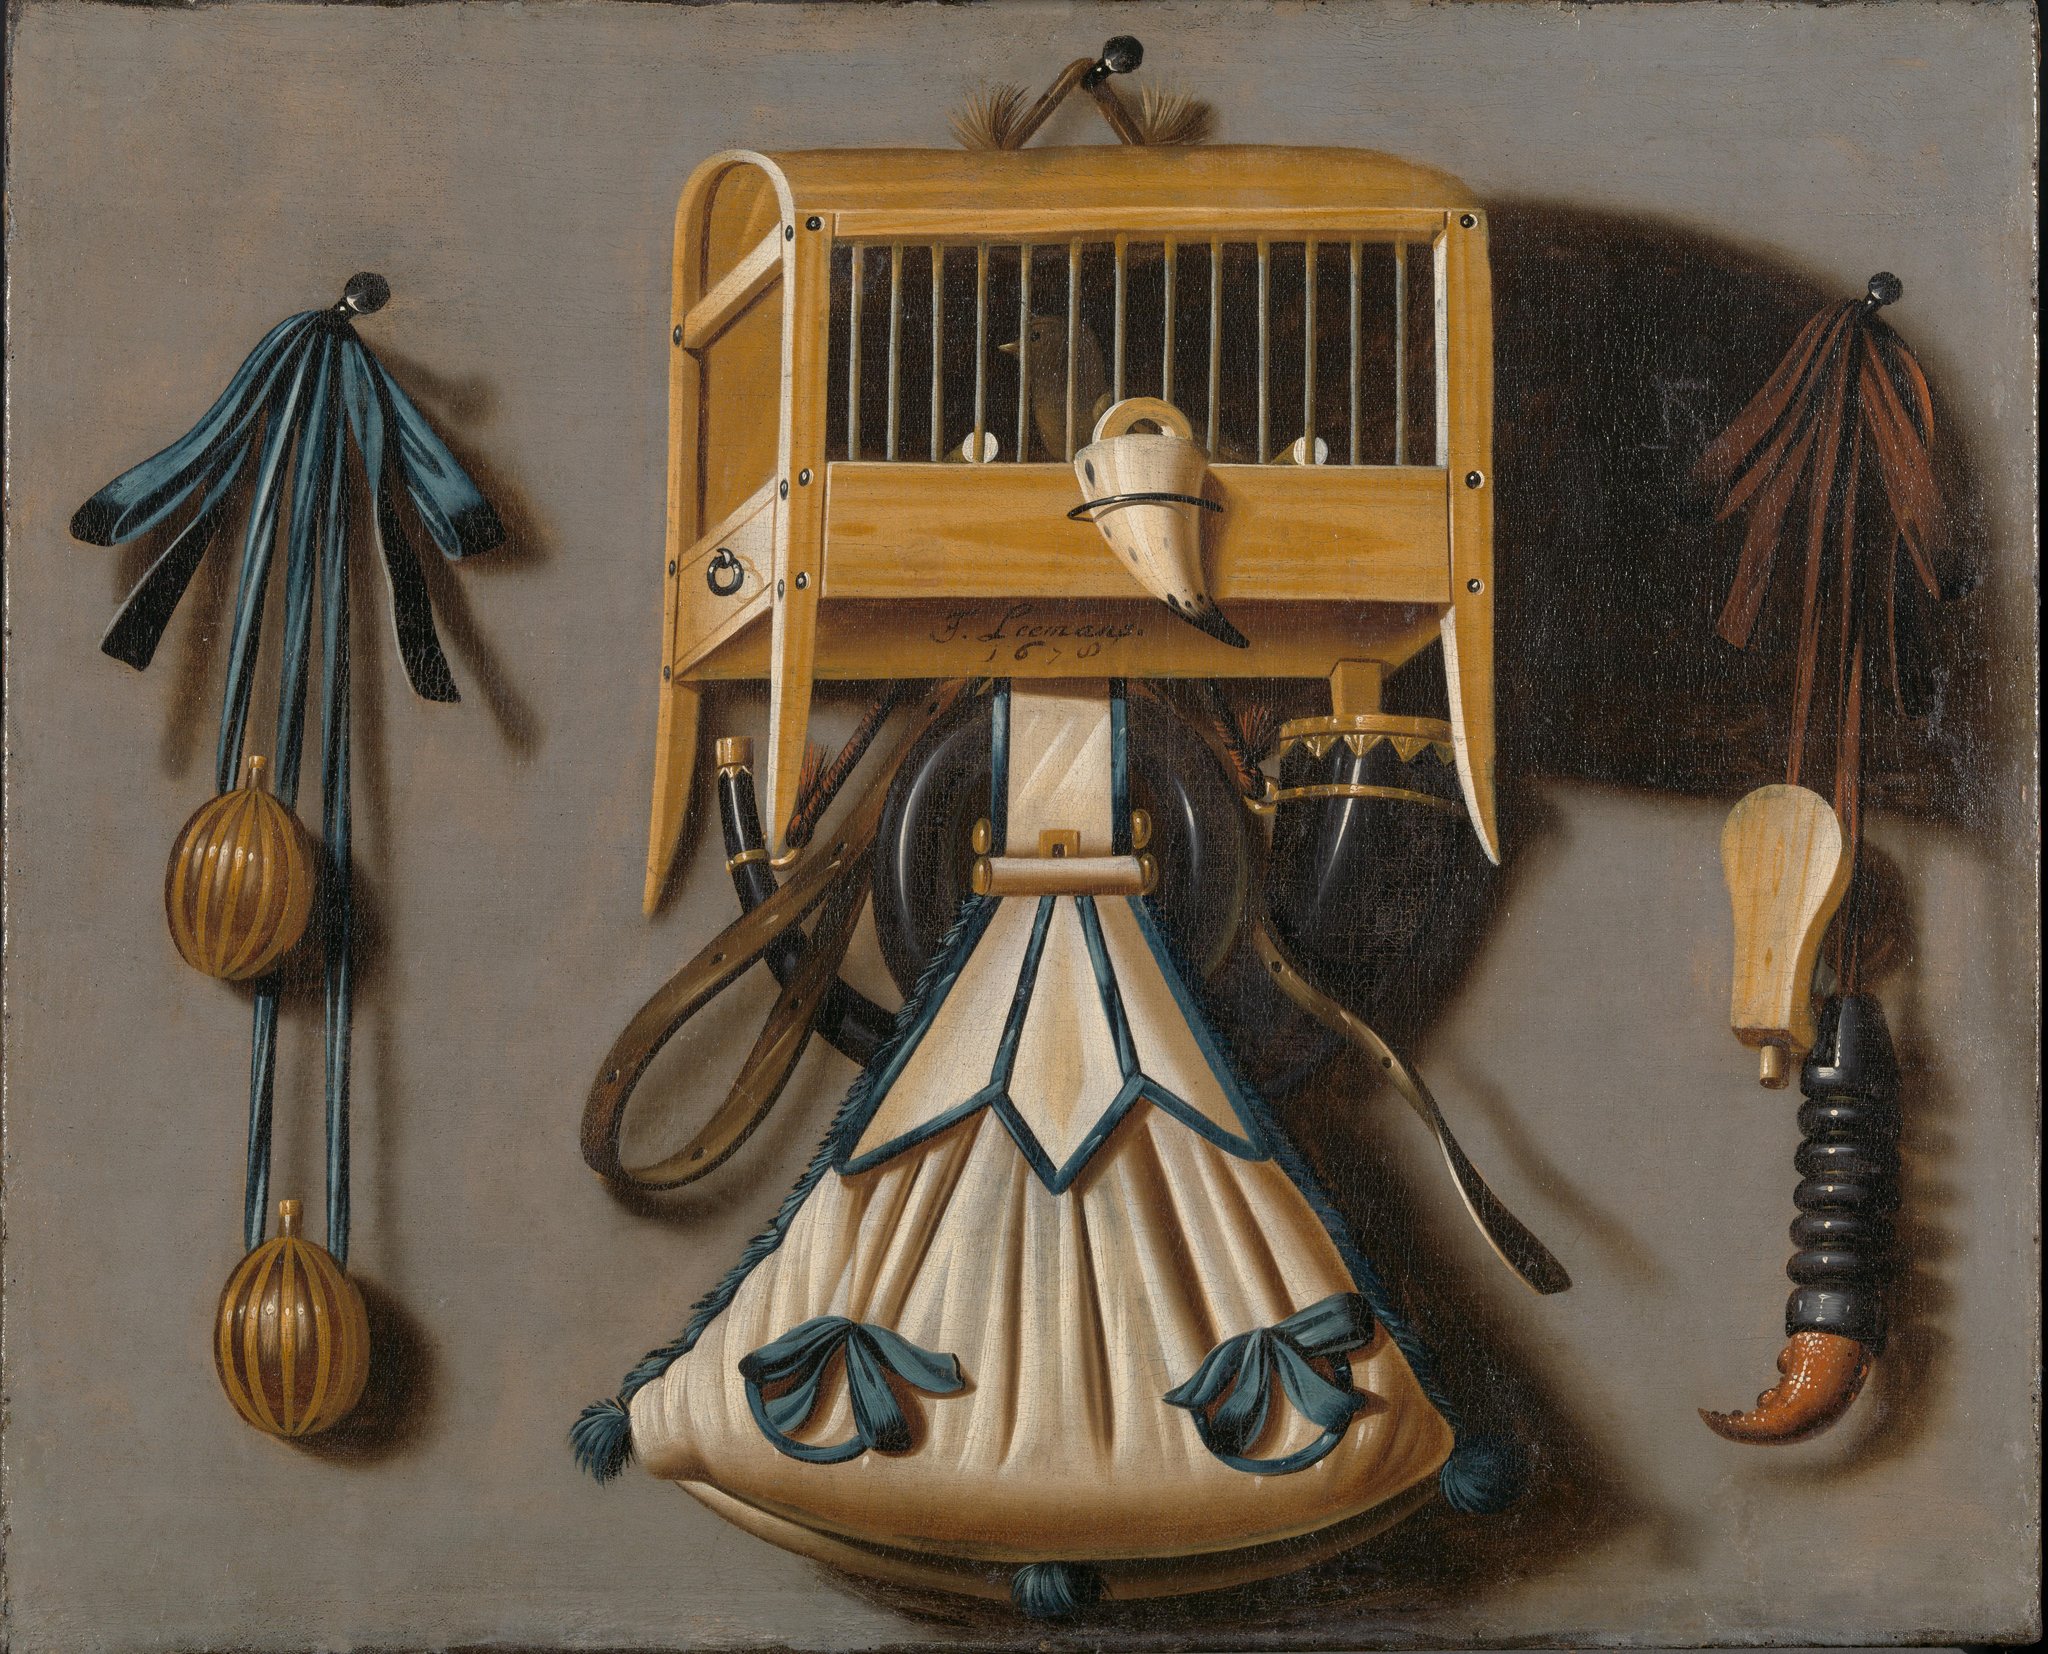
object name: trompe l'oeil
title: Still Life with Implements of the Hunt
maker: johannes leemans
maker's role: painter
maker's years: 1633-1686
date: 1678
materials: canvas, oil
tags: hunting, chase, still life of related objects, bird in a cage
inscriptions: signature and date: ‘J. Leemans. 1678’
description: Stilleven met jachtgerei. Trompe-l'oeil met een vogelkooi en verschillende objecten gebruikt bij de jacht (weitas en jachthoorn) hangend tegen een muur. Links twee ballen aan een strik, rechts een kruithoorn.